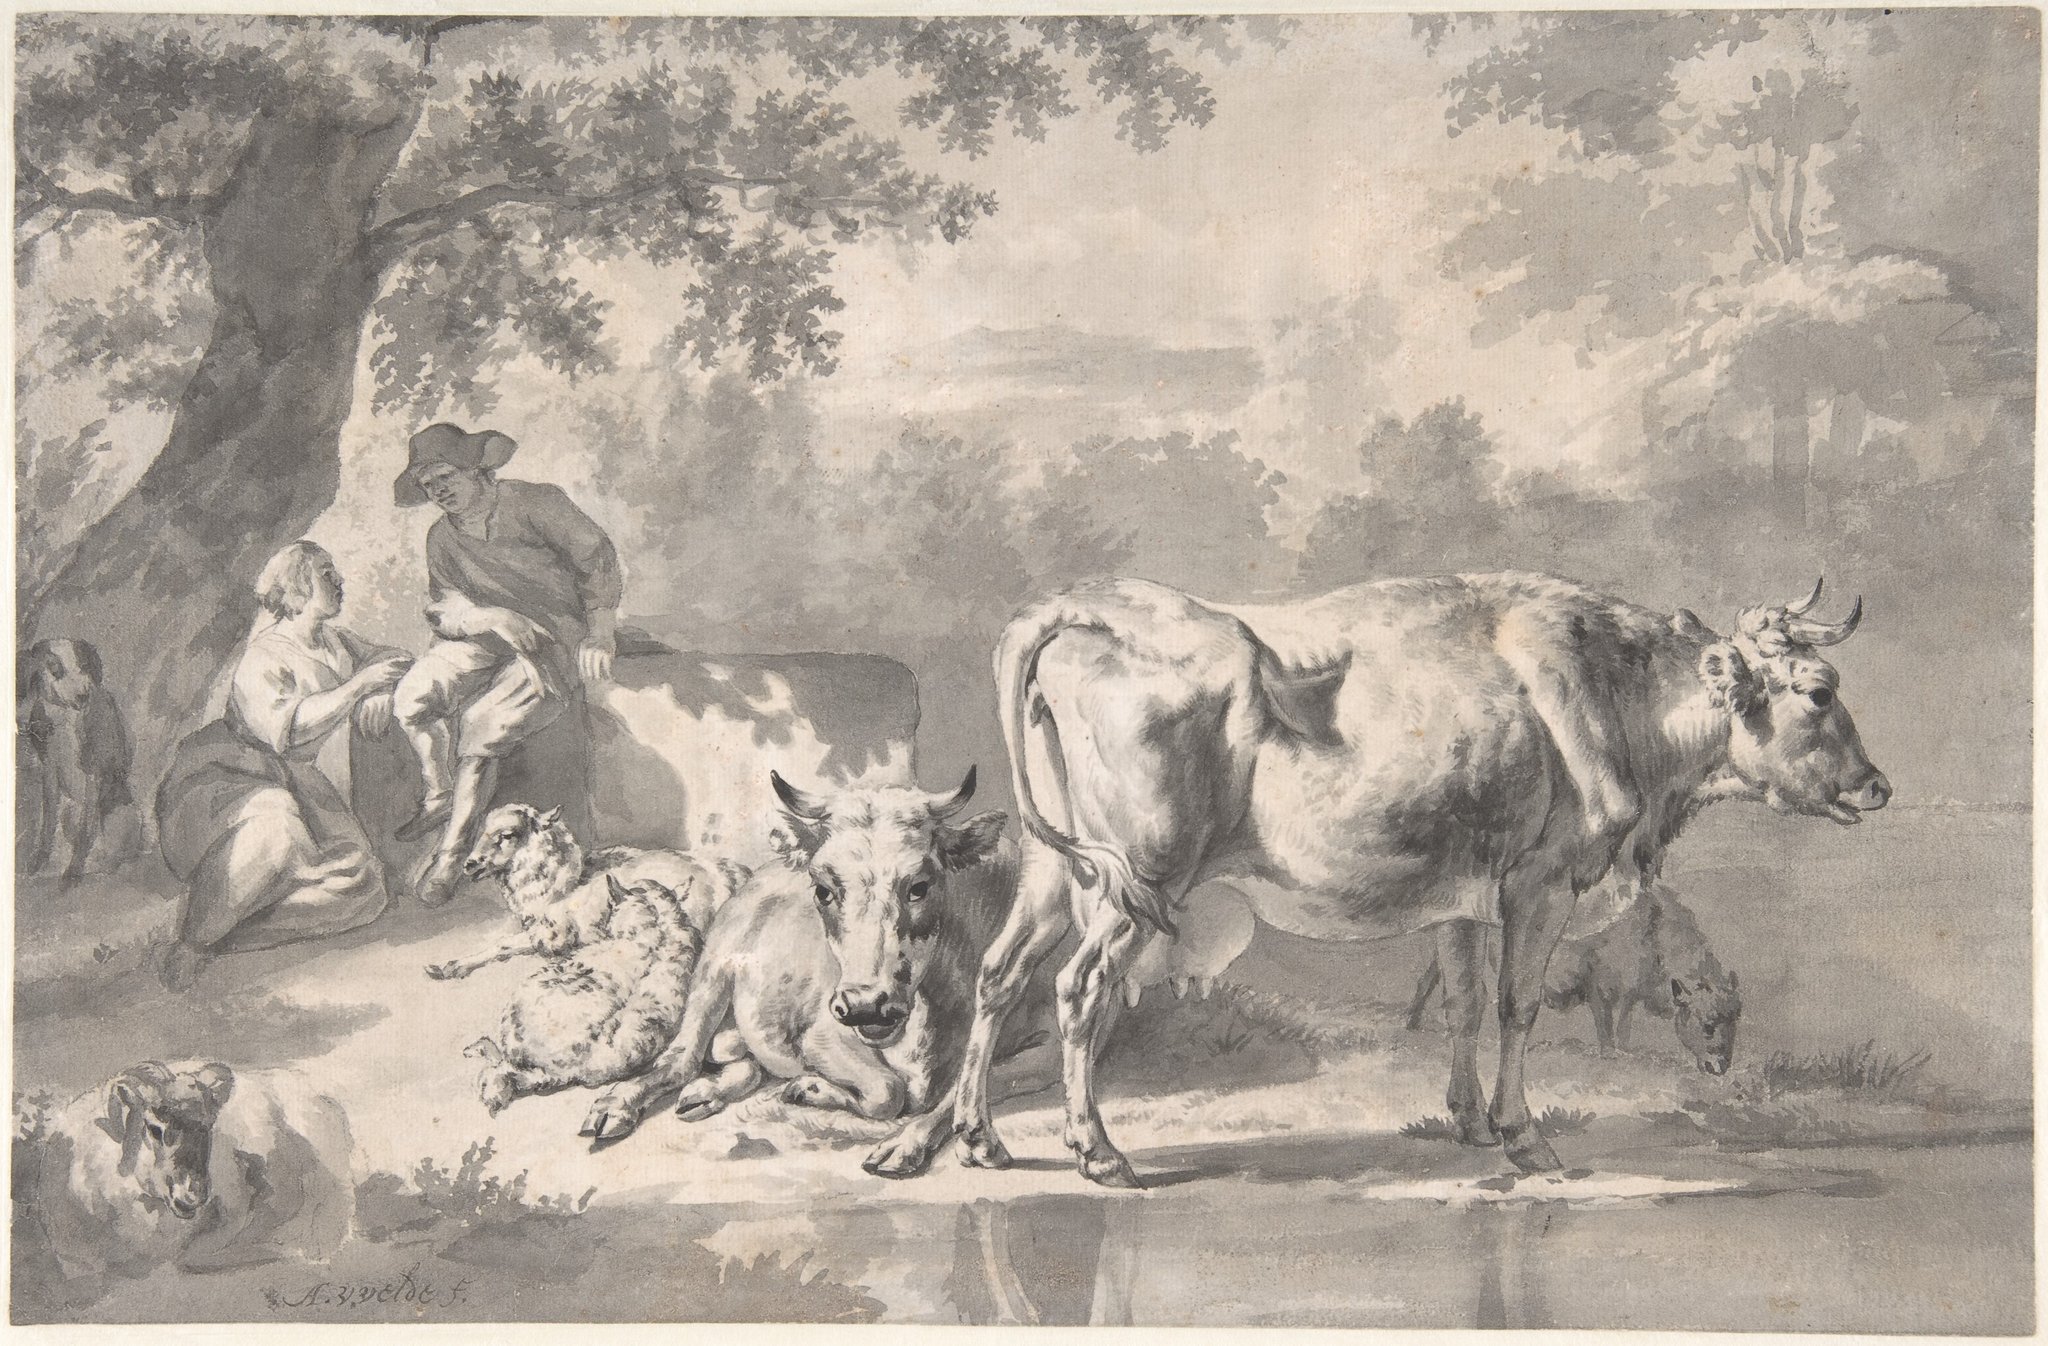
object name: drawing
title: Peasants with Cattle and Sheep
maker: adriaen van de velde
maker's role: artist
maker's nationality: dutch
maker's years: 1636-1672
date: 1634-1666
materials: chalk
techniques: brush, wash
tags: men,women,cows,dogs,sheep